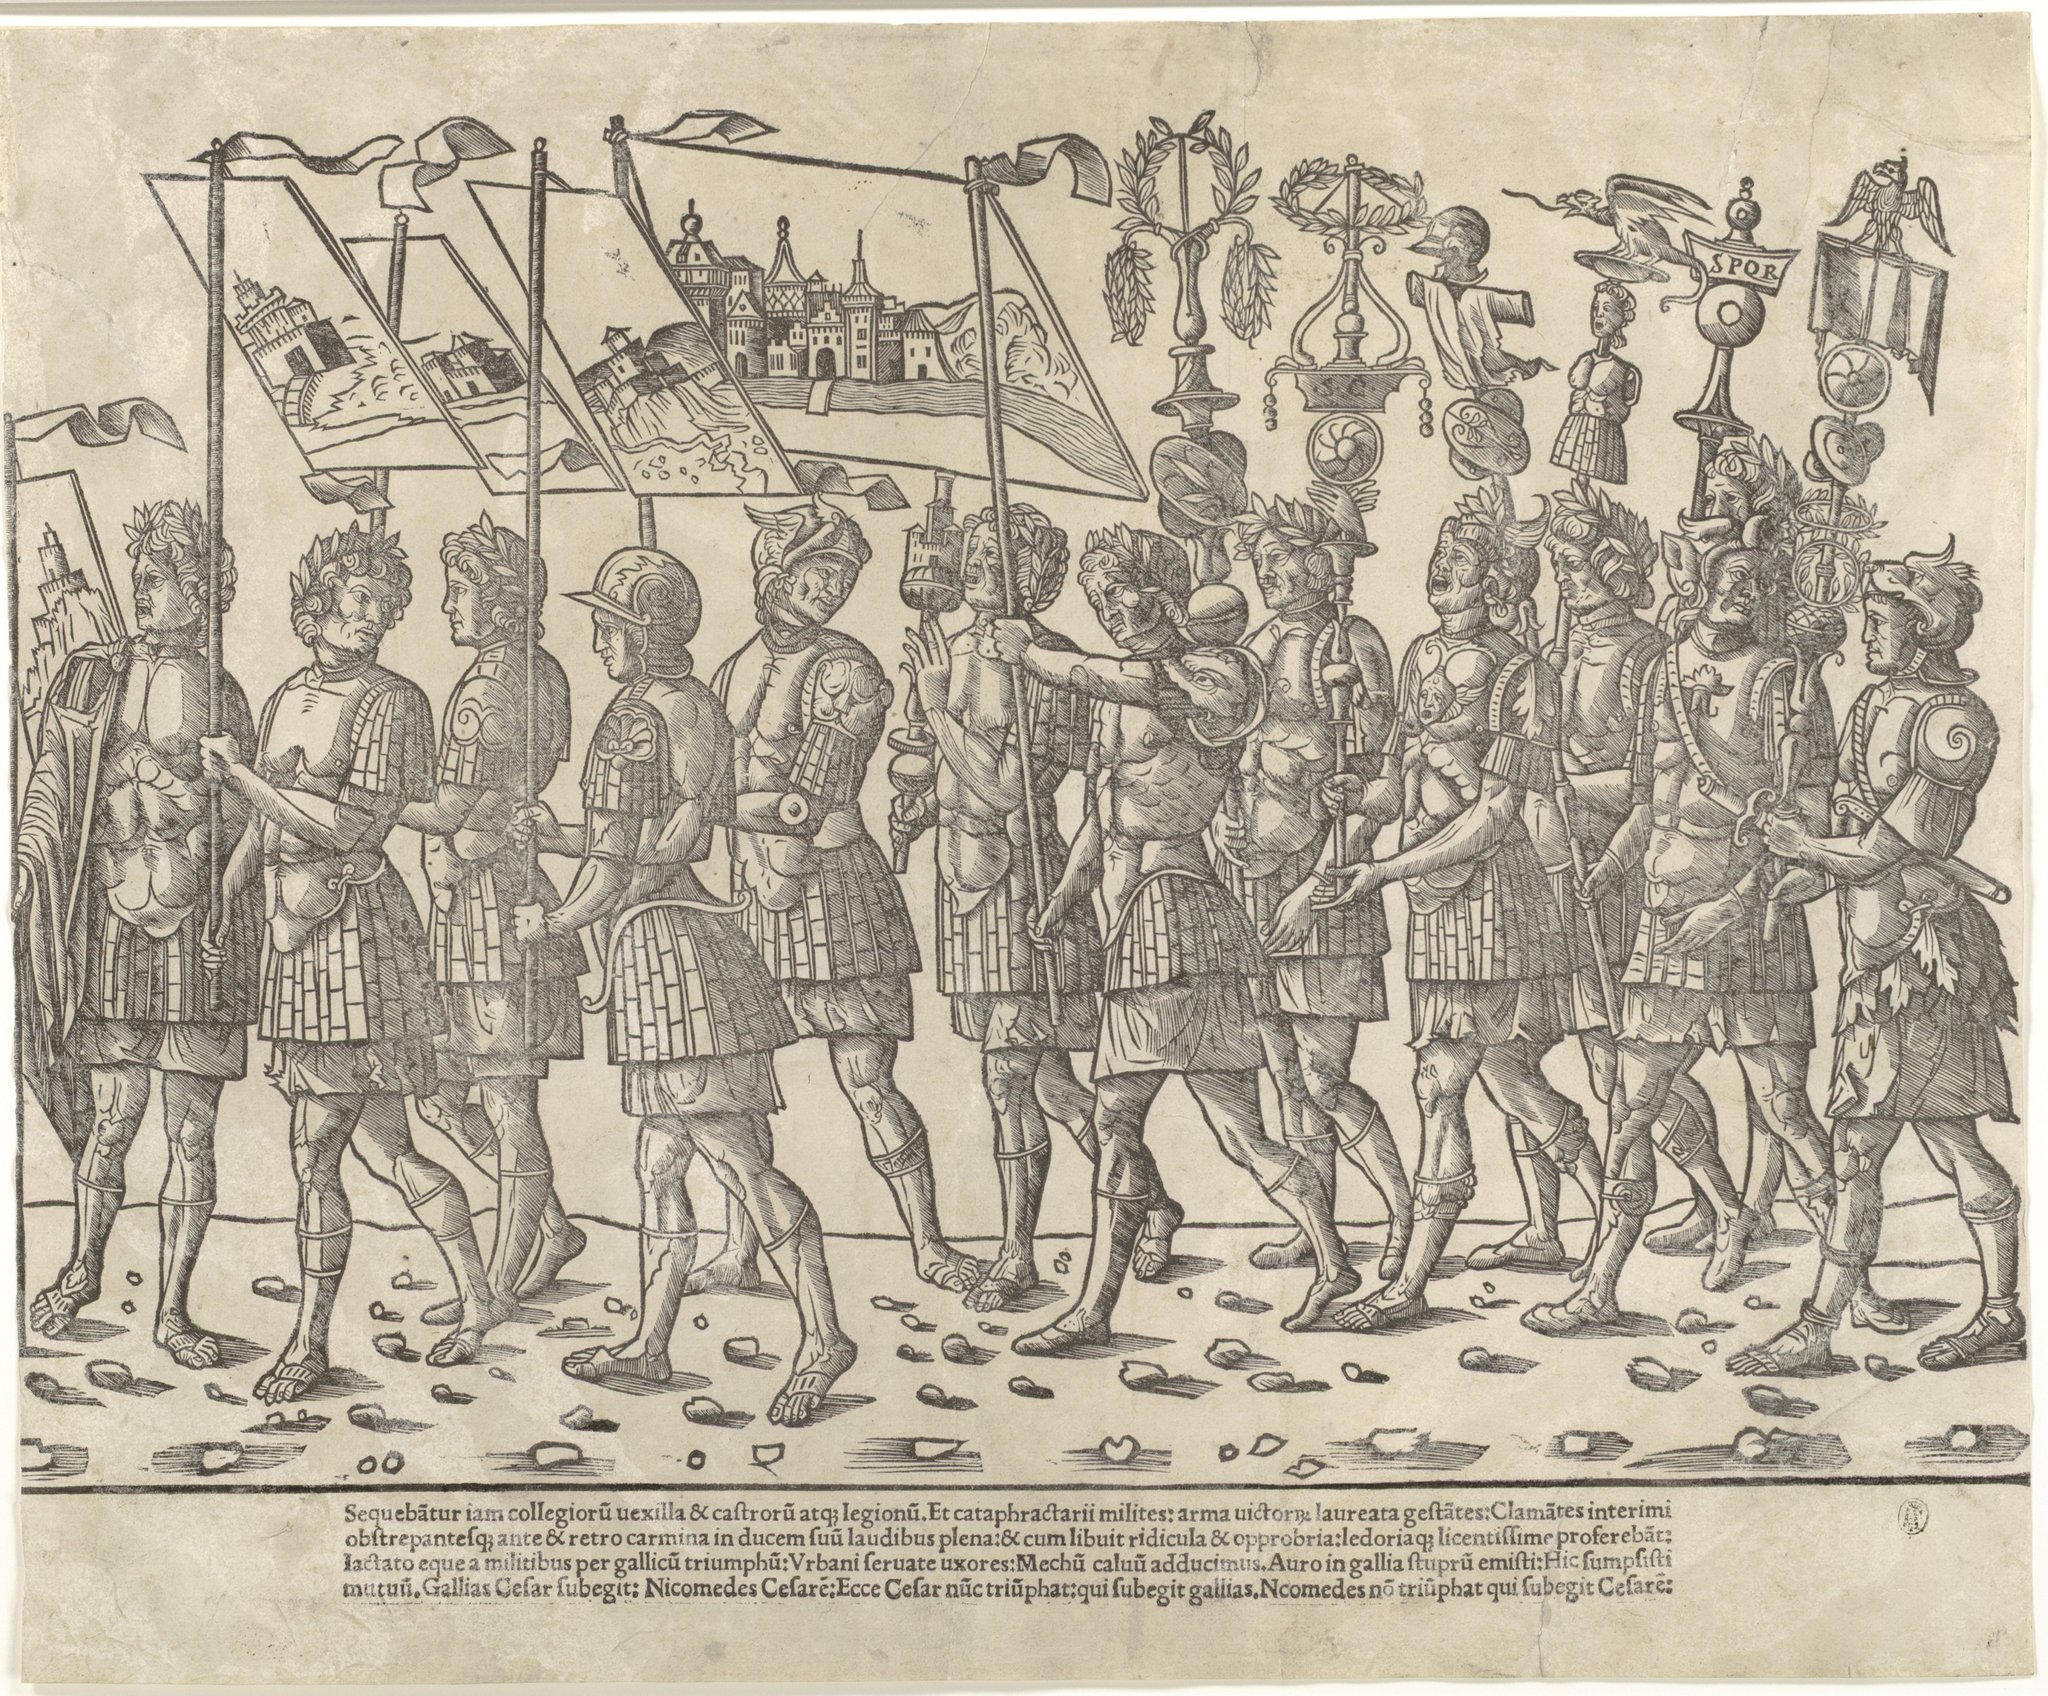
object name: print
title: Figures carrying standards and trophies, from "The Triumph of Caesar"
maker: jacob of strasbourg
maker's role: artist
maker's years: 1494-1530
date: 1504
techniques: woodcut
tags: soldiers,flags,trophies